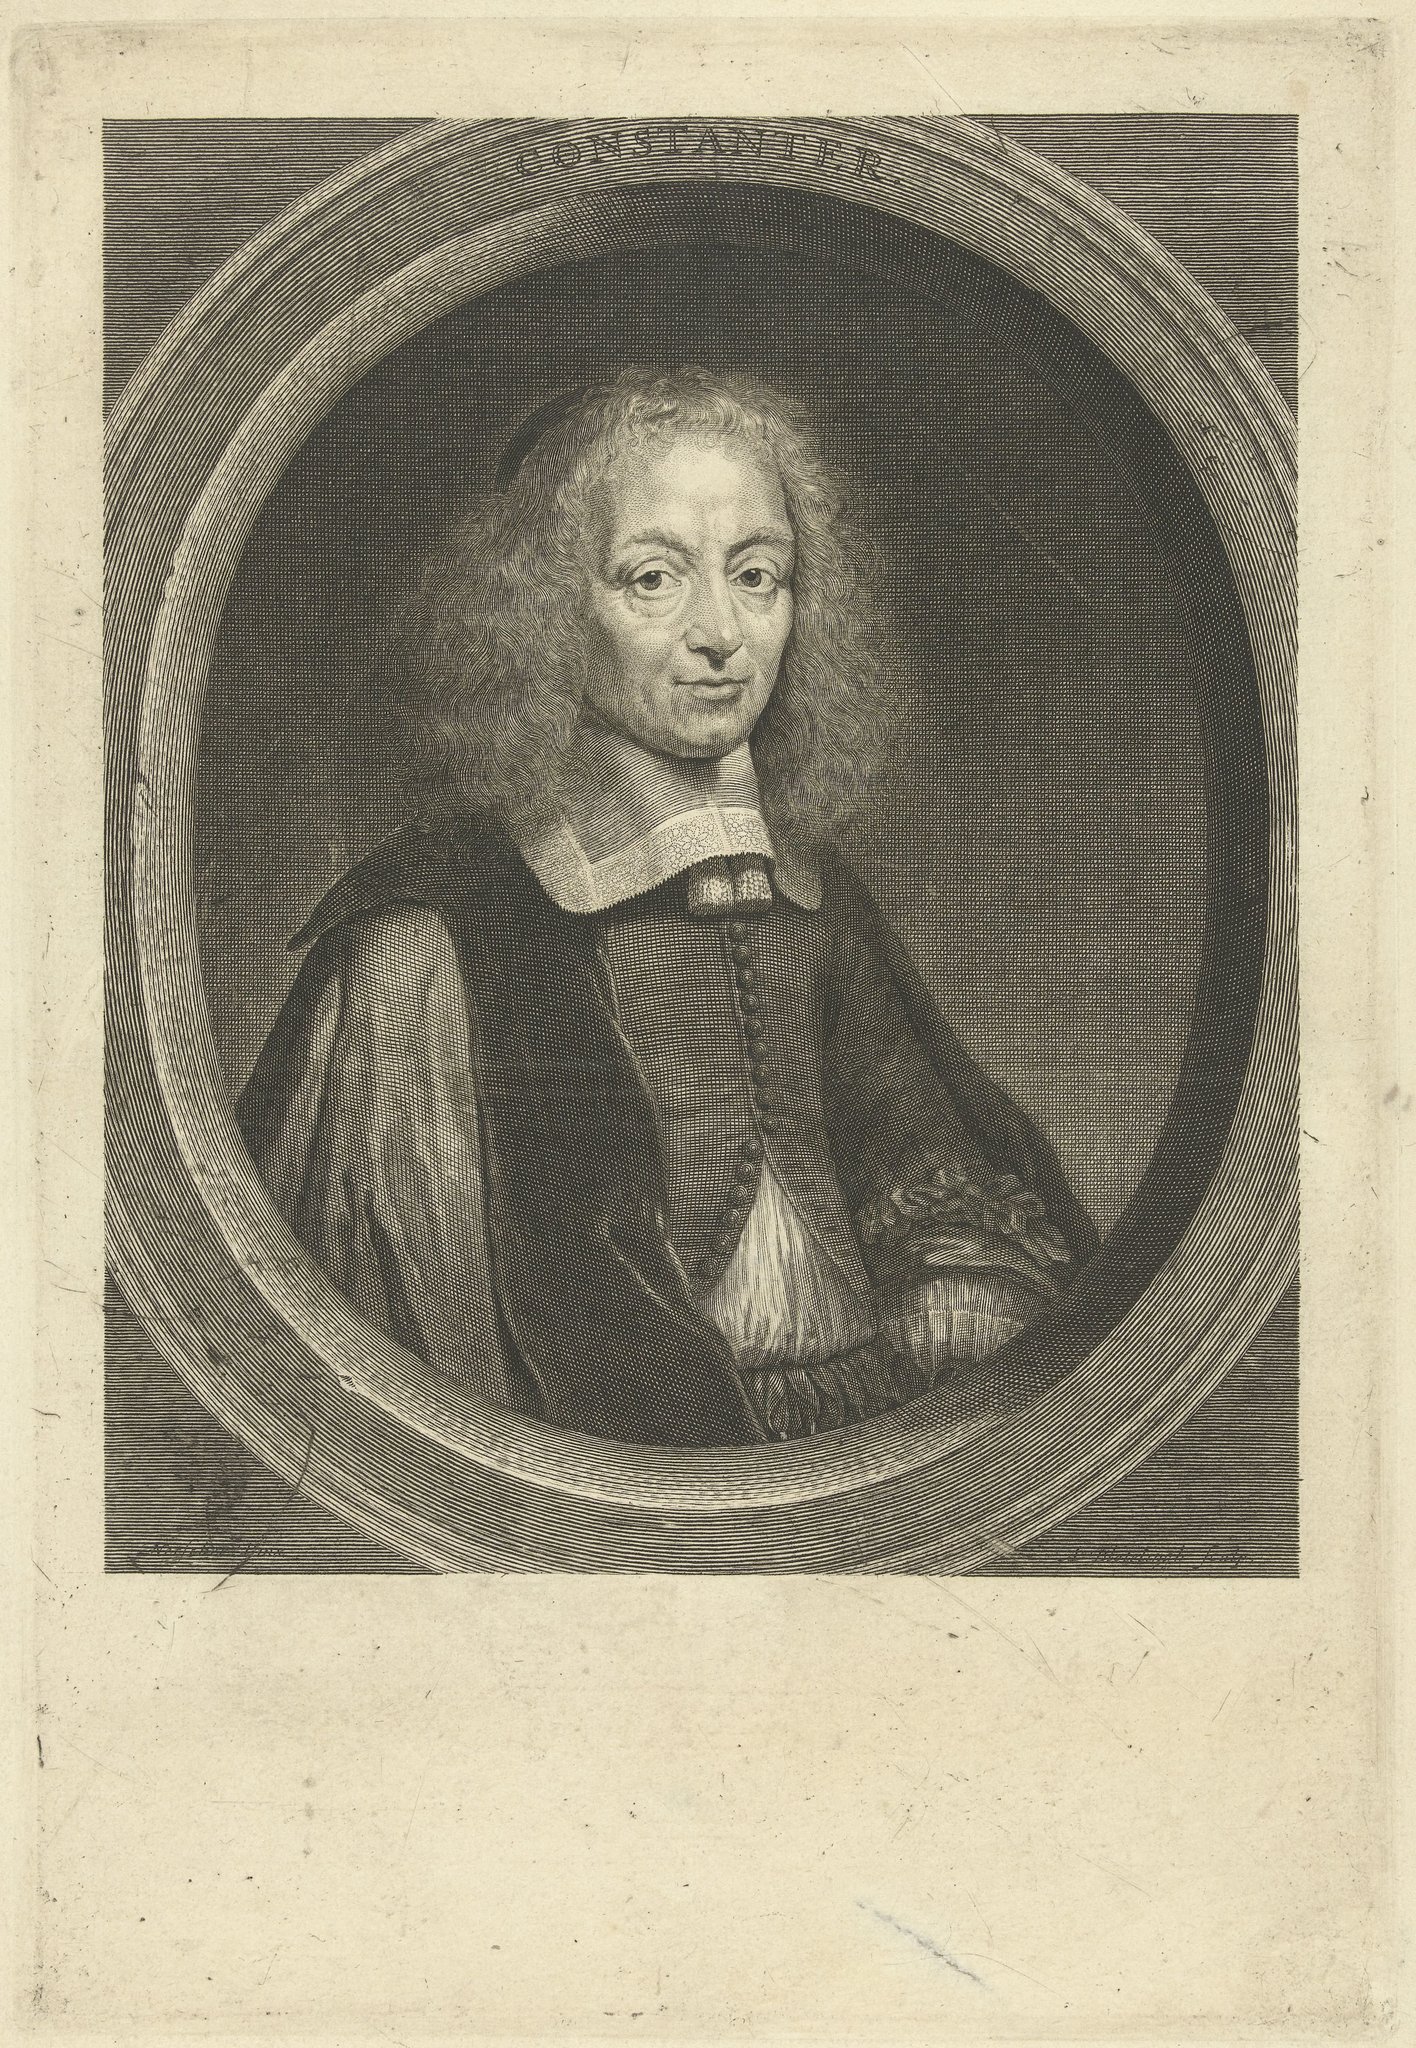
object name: print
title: Portret van Constantijn Huygens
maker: abraham bloteling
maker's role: draughtsman, print maker, publisher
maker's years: 1640-1690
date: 1672-1690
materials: paper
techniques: engraving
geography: amsterdam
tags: constantijn huygens (i)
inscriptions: collector's mark: Lugt 2228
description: Borstbeeld van Constantijn Huygens heer van Zuylichem, secretaris van Frederik Hendrik, Willem II en Willem III, en dichter, in ovaal.